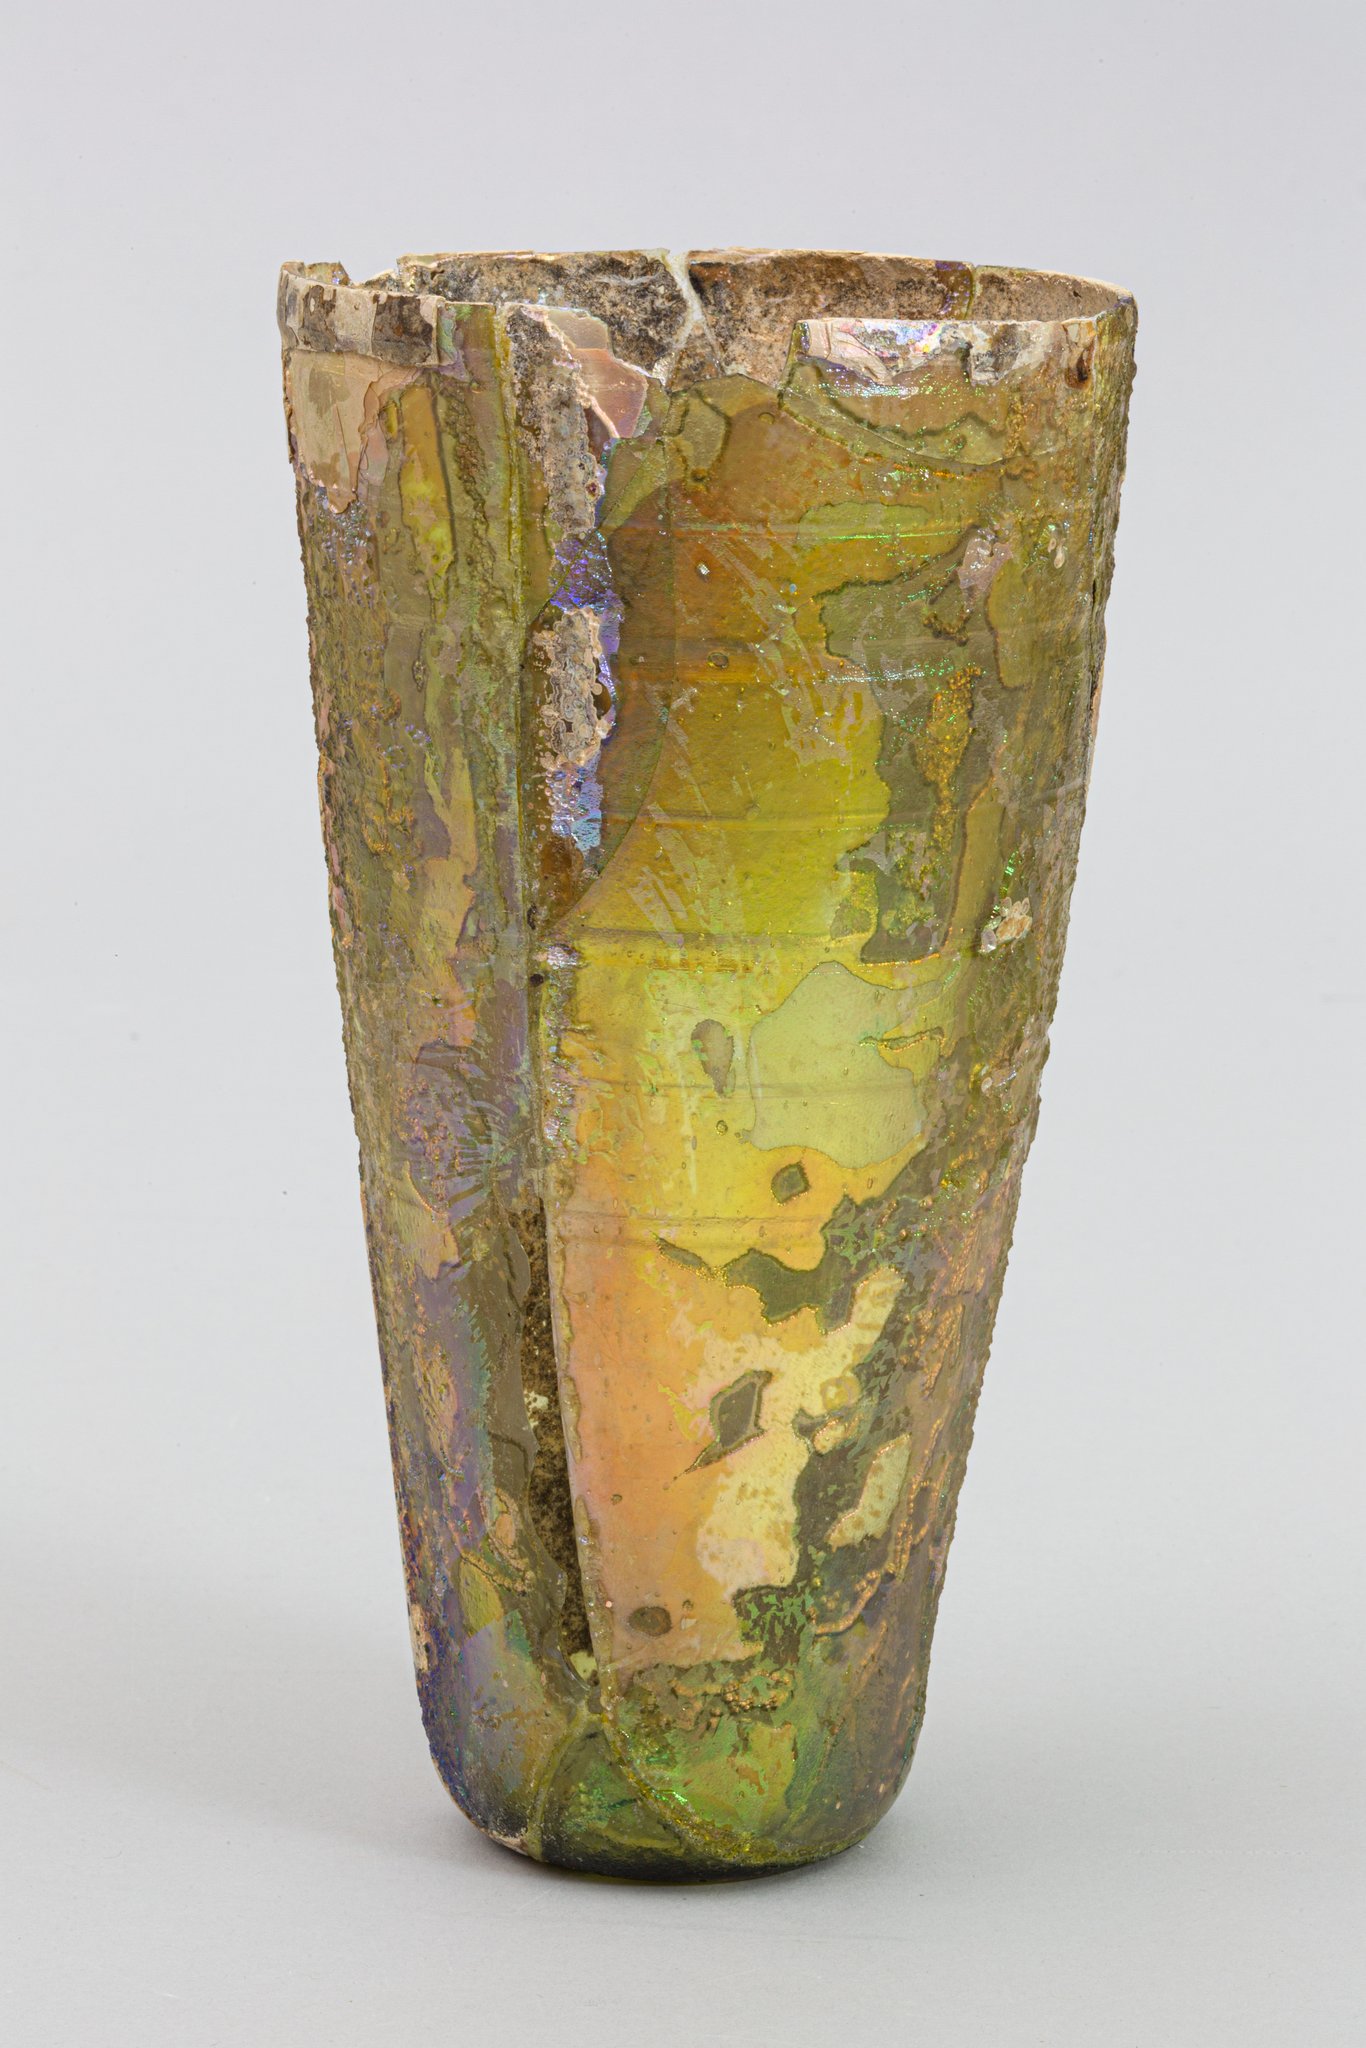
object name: beaker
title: Glass beaker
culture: roman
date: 1-200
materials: glass